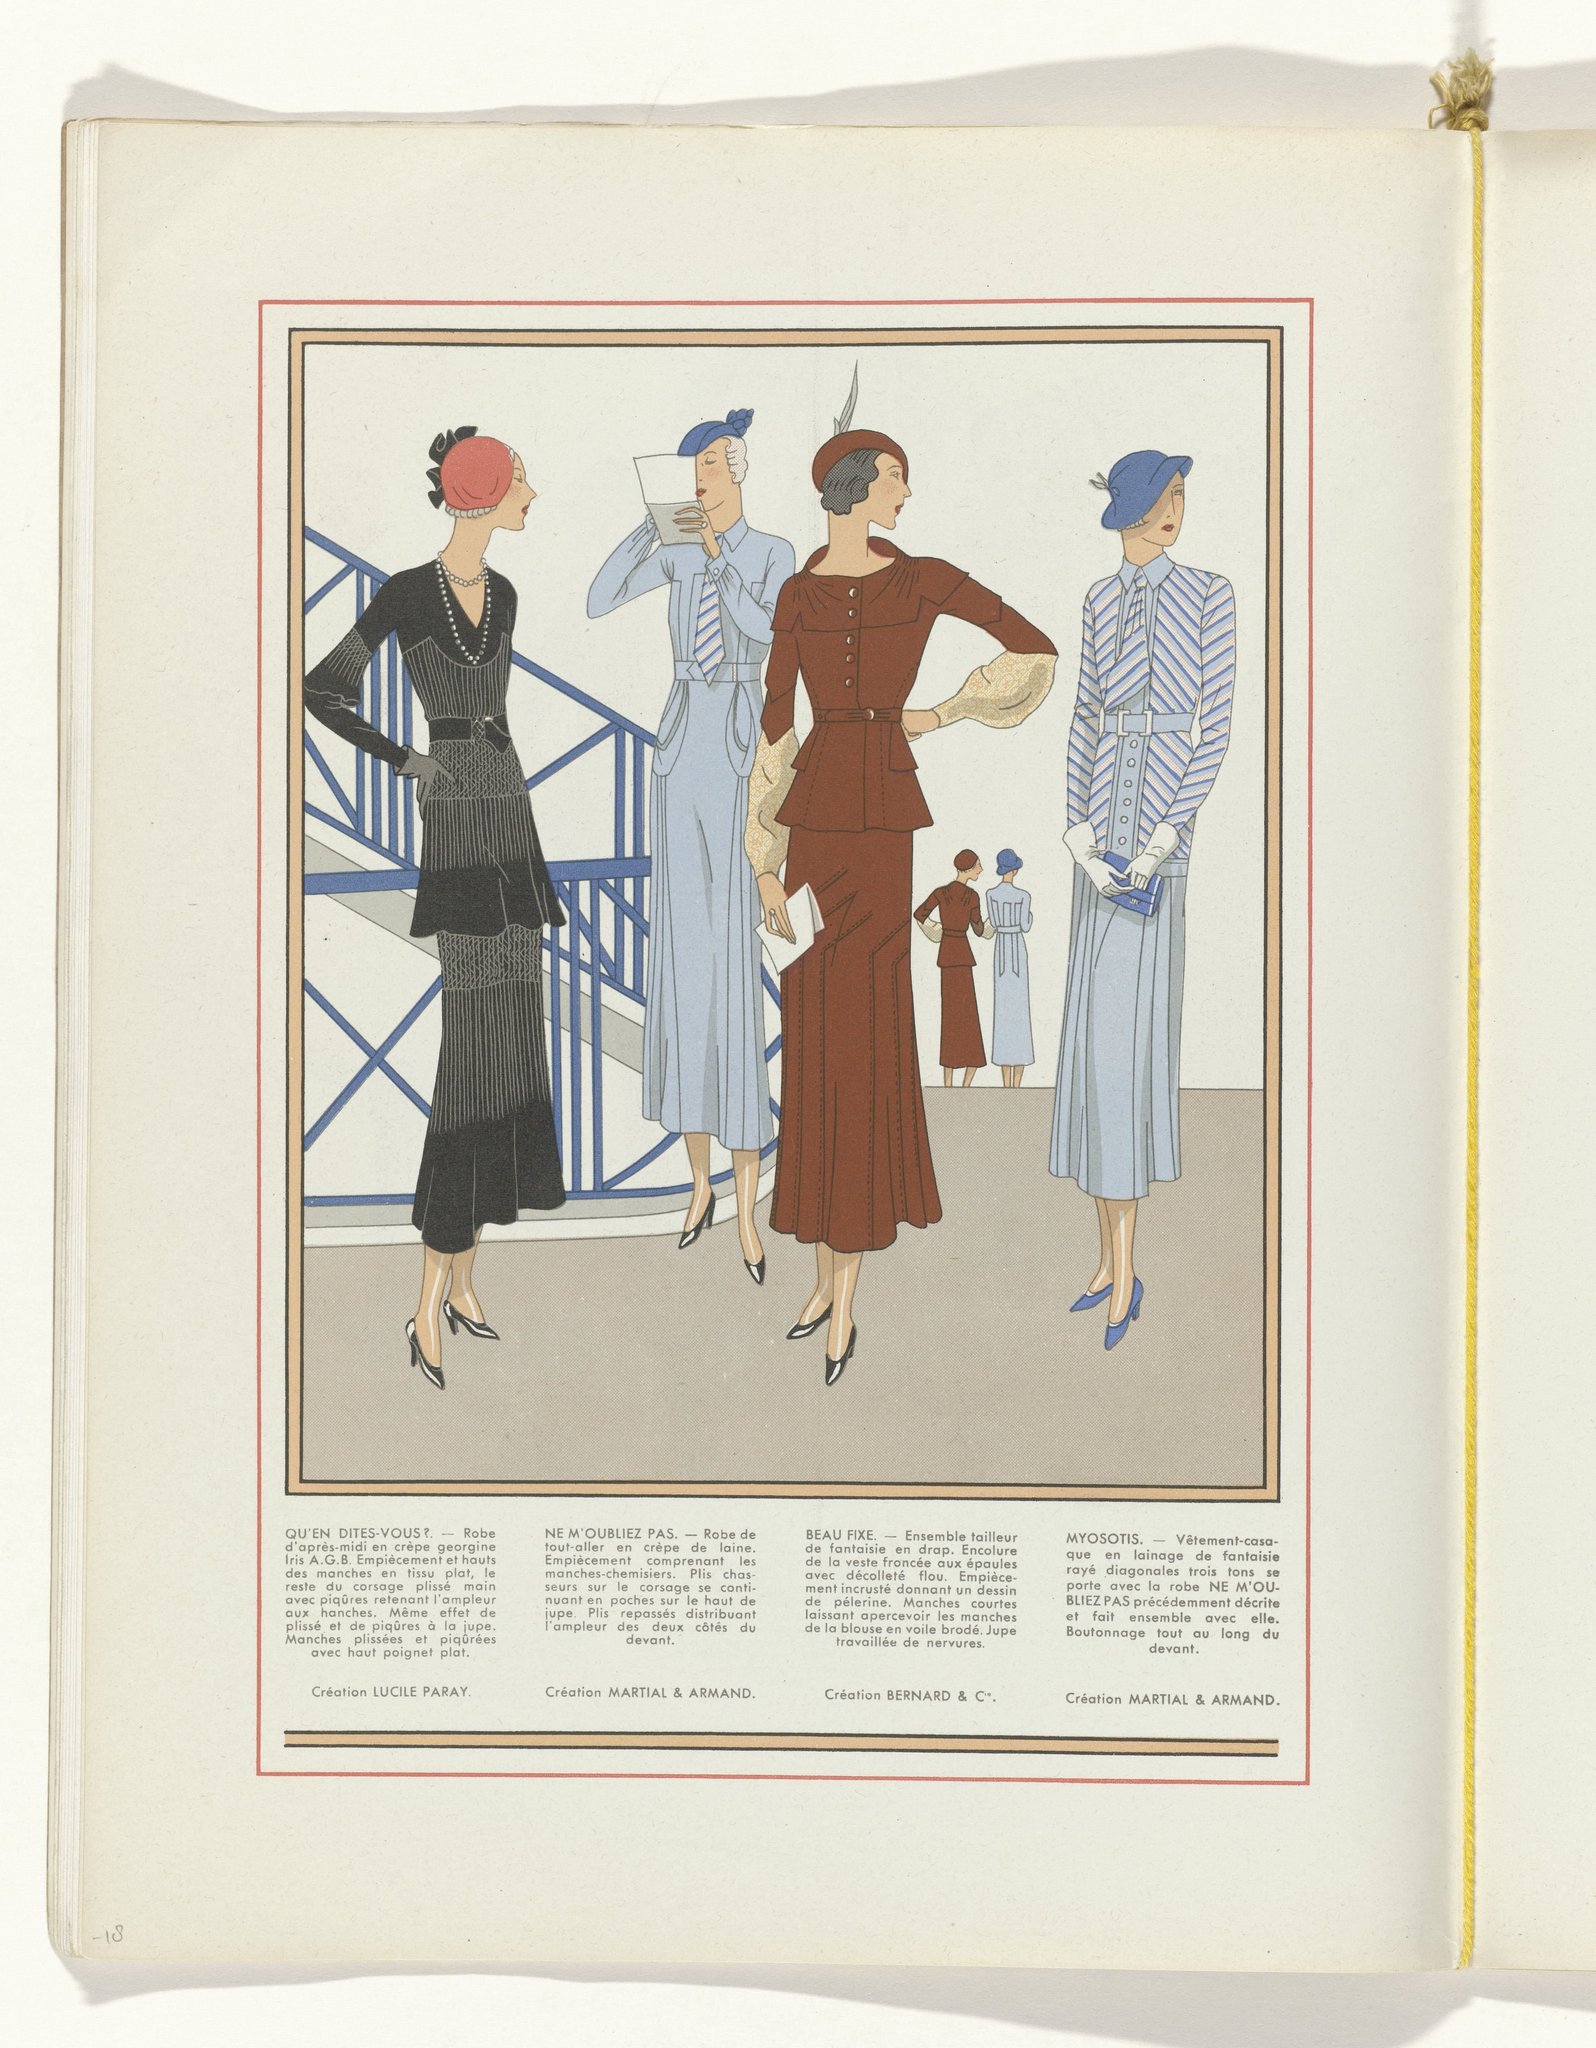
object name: fashion print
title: Art - Goût - Beauté, Feuillets de l' élégance féminine, Mars 1932, No. 139, 12e Année, p. 18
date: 1932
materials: paper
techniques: printing, lithograph, photography, pochoir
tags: dress, gown: day dress (+ women's clothes), ensembles of pieces of clothing (tailleur) (+ women's clothes), fashion plates, head-gear: hat (+ women's clothes)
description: Dameskleding van Lucile Paray, Martial et Armand en Bernard. Pagina uit het modetijdschrift Art-Goût-Beauté (1920-1933).